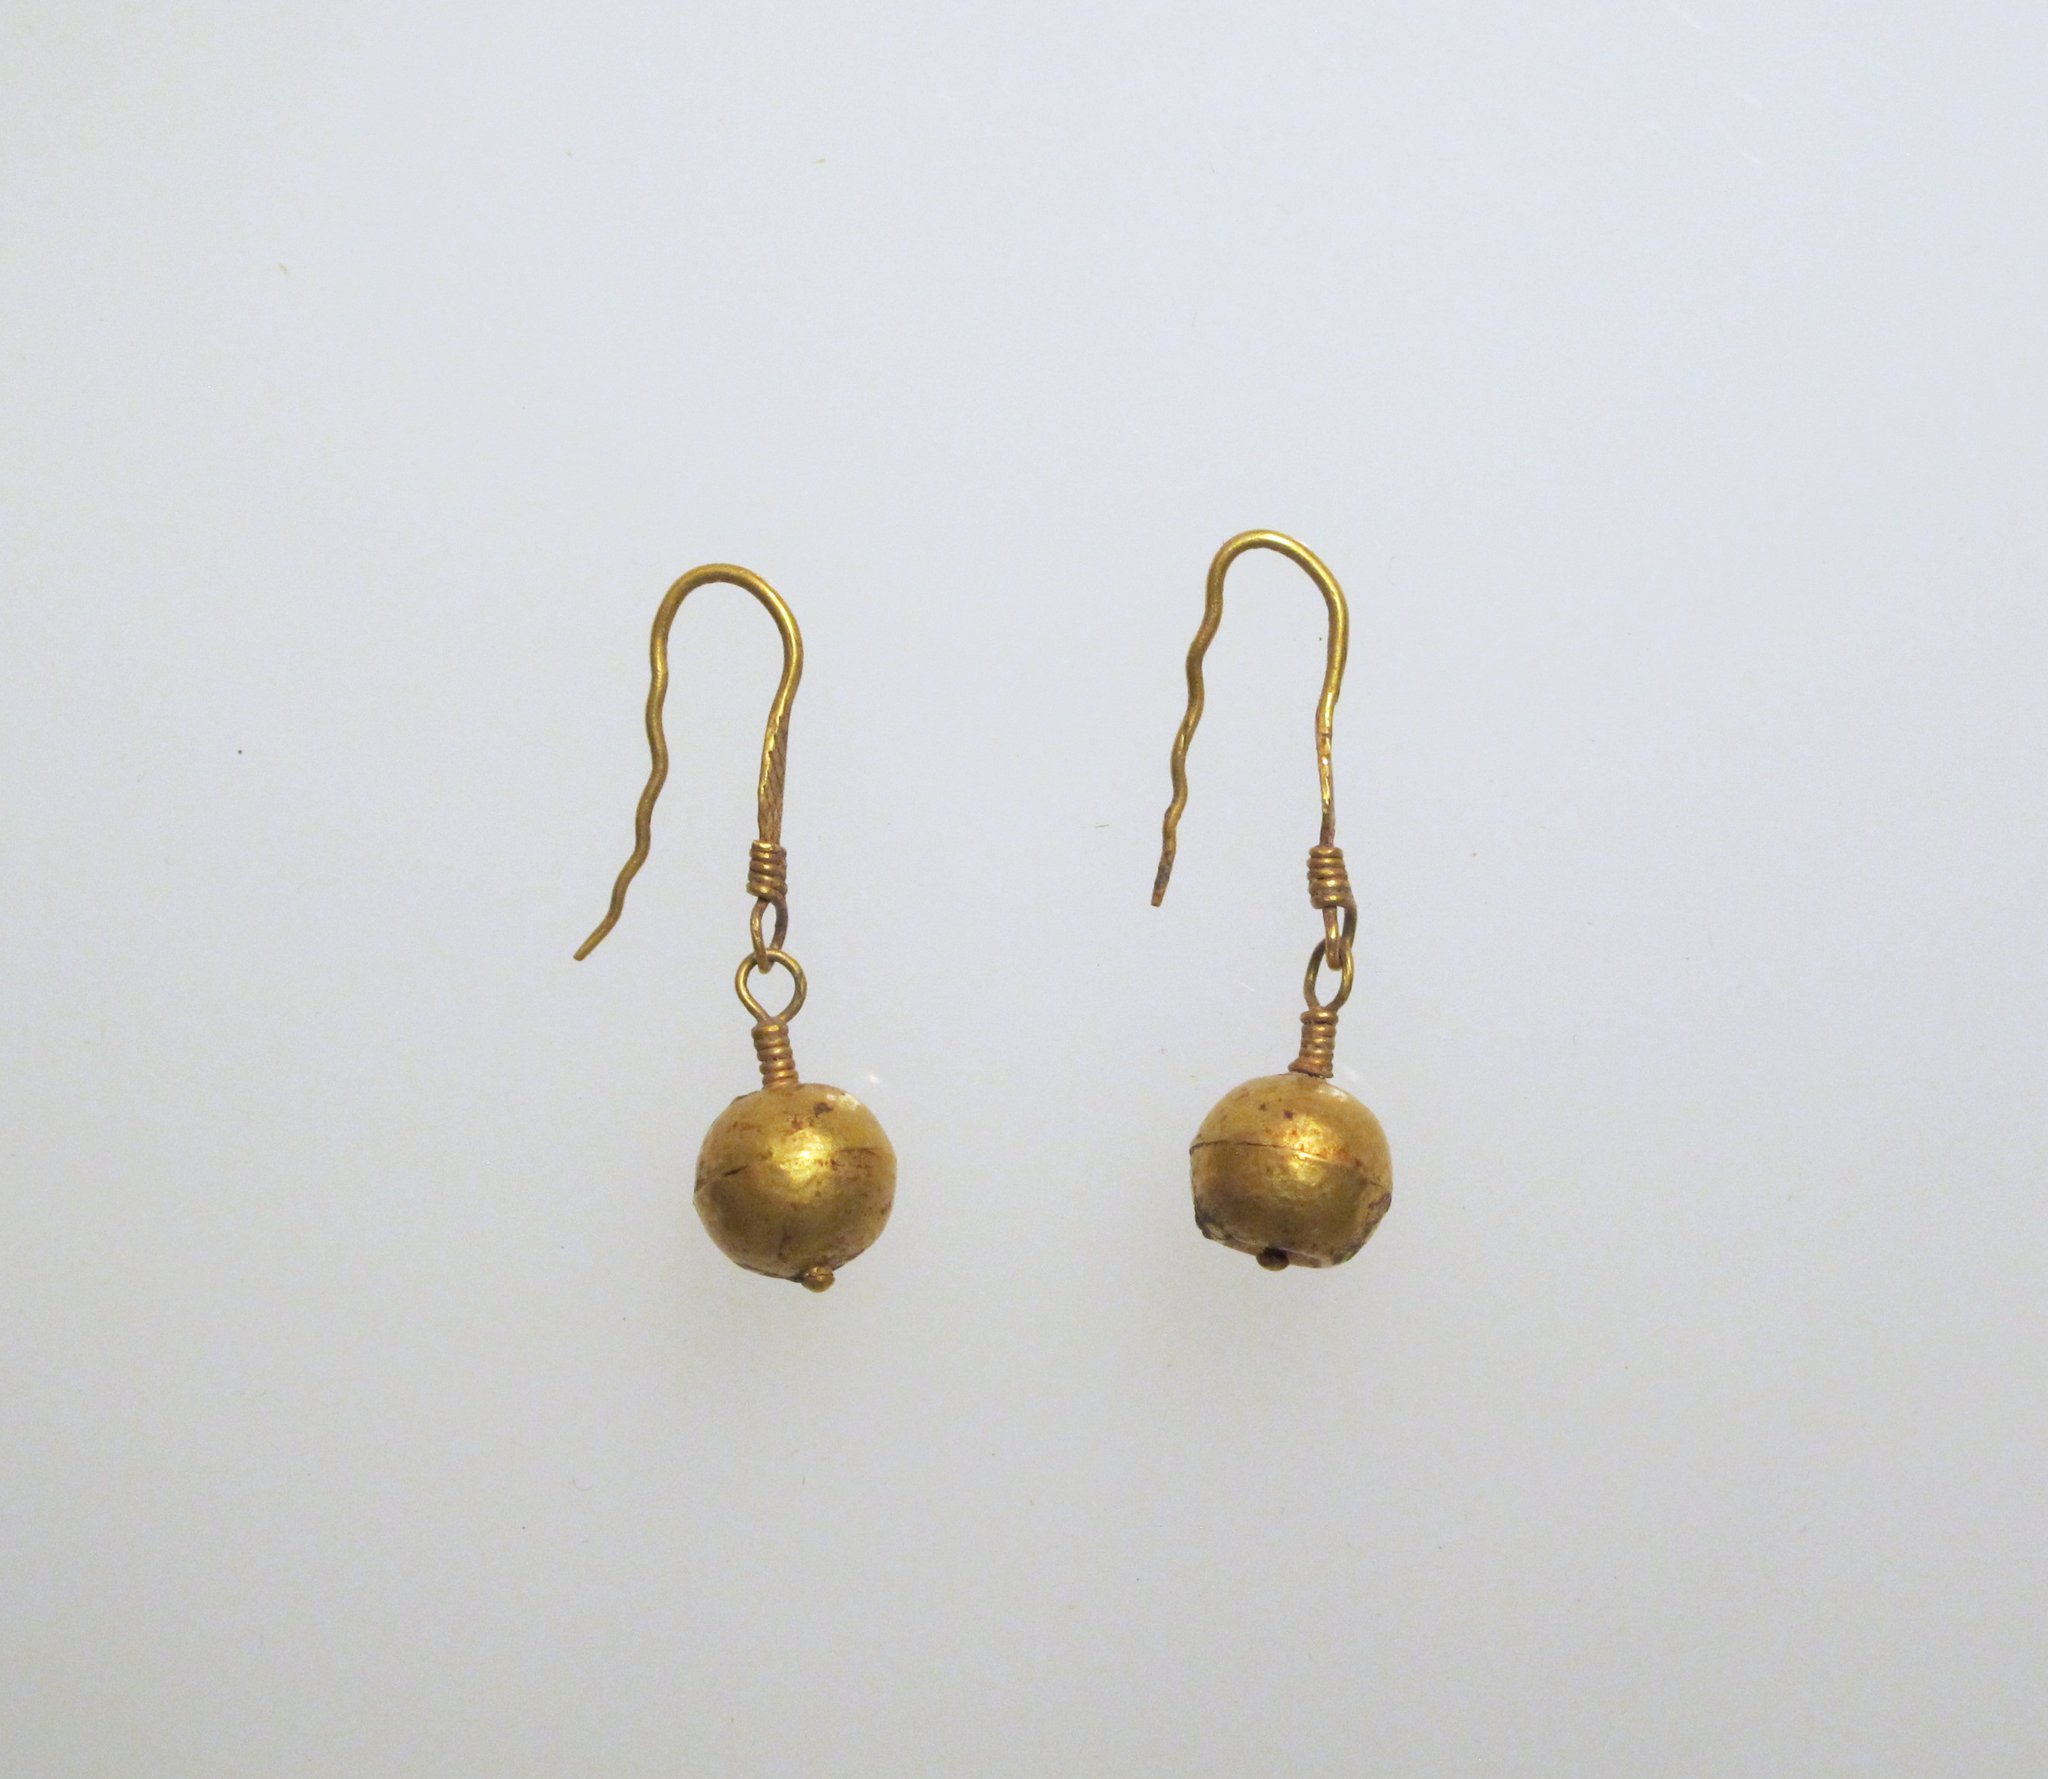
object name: earring with pendant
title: Earring with pendants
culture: roman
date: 100 BCE-300 CE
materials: gold